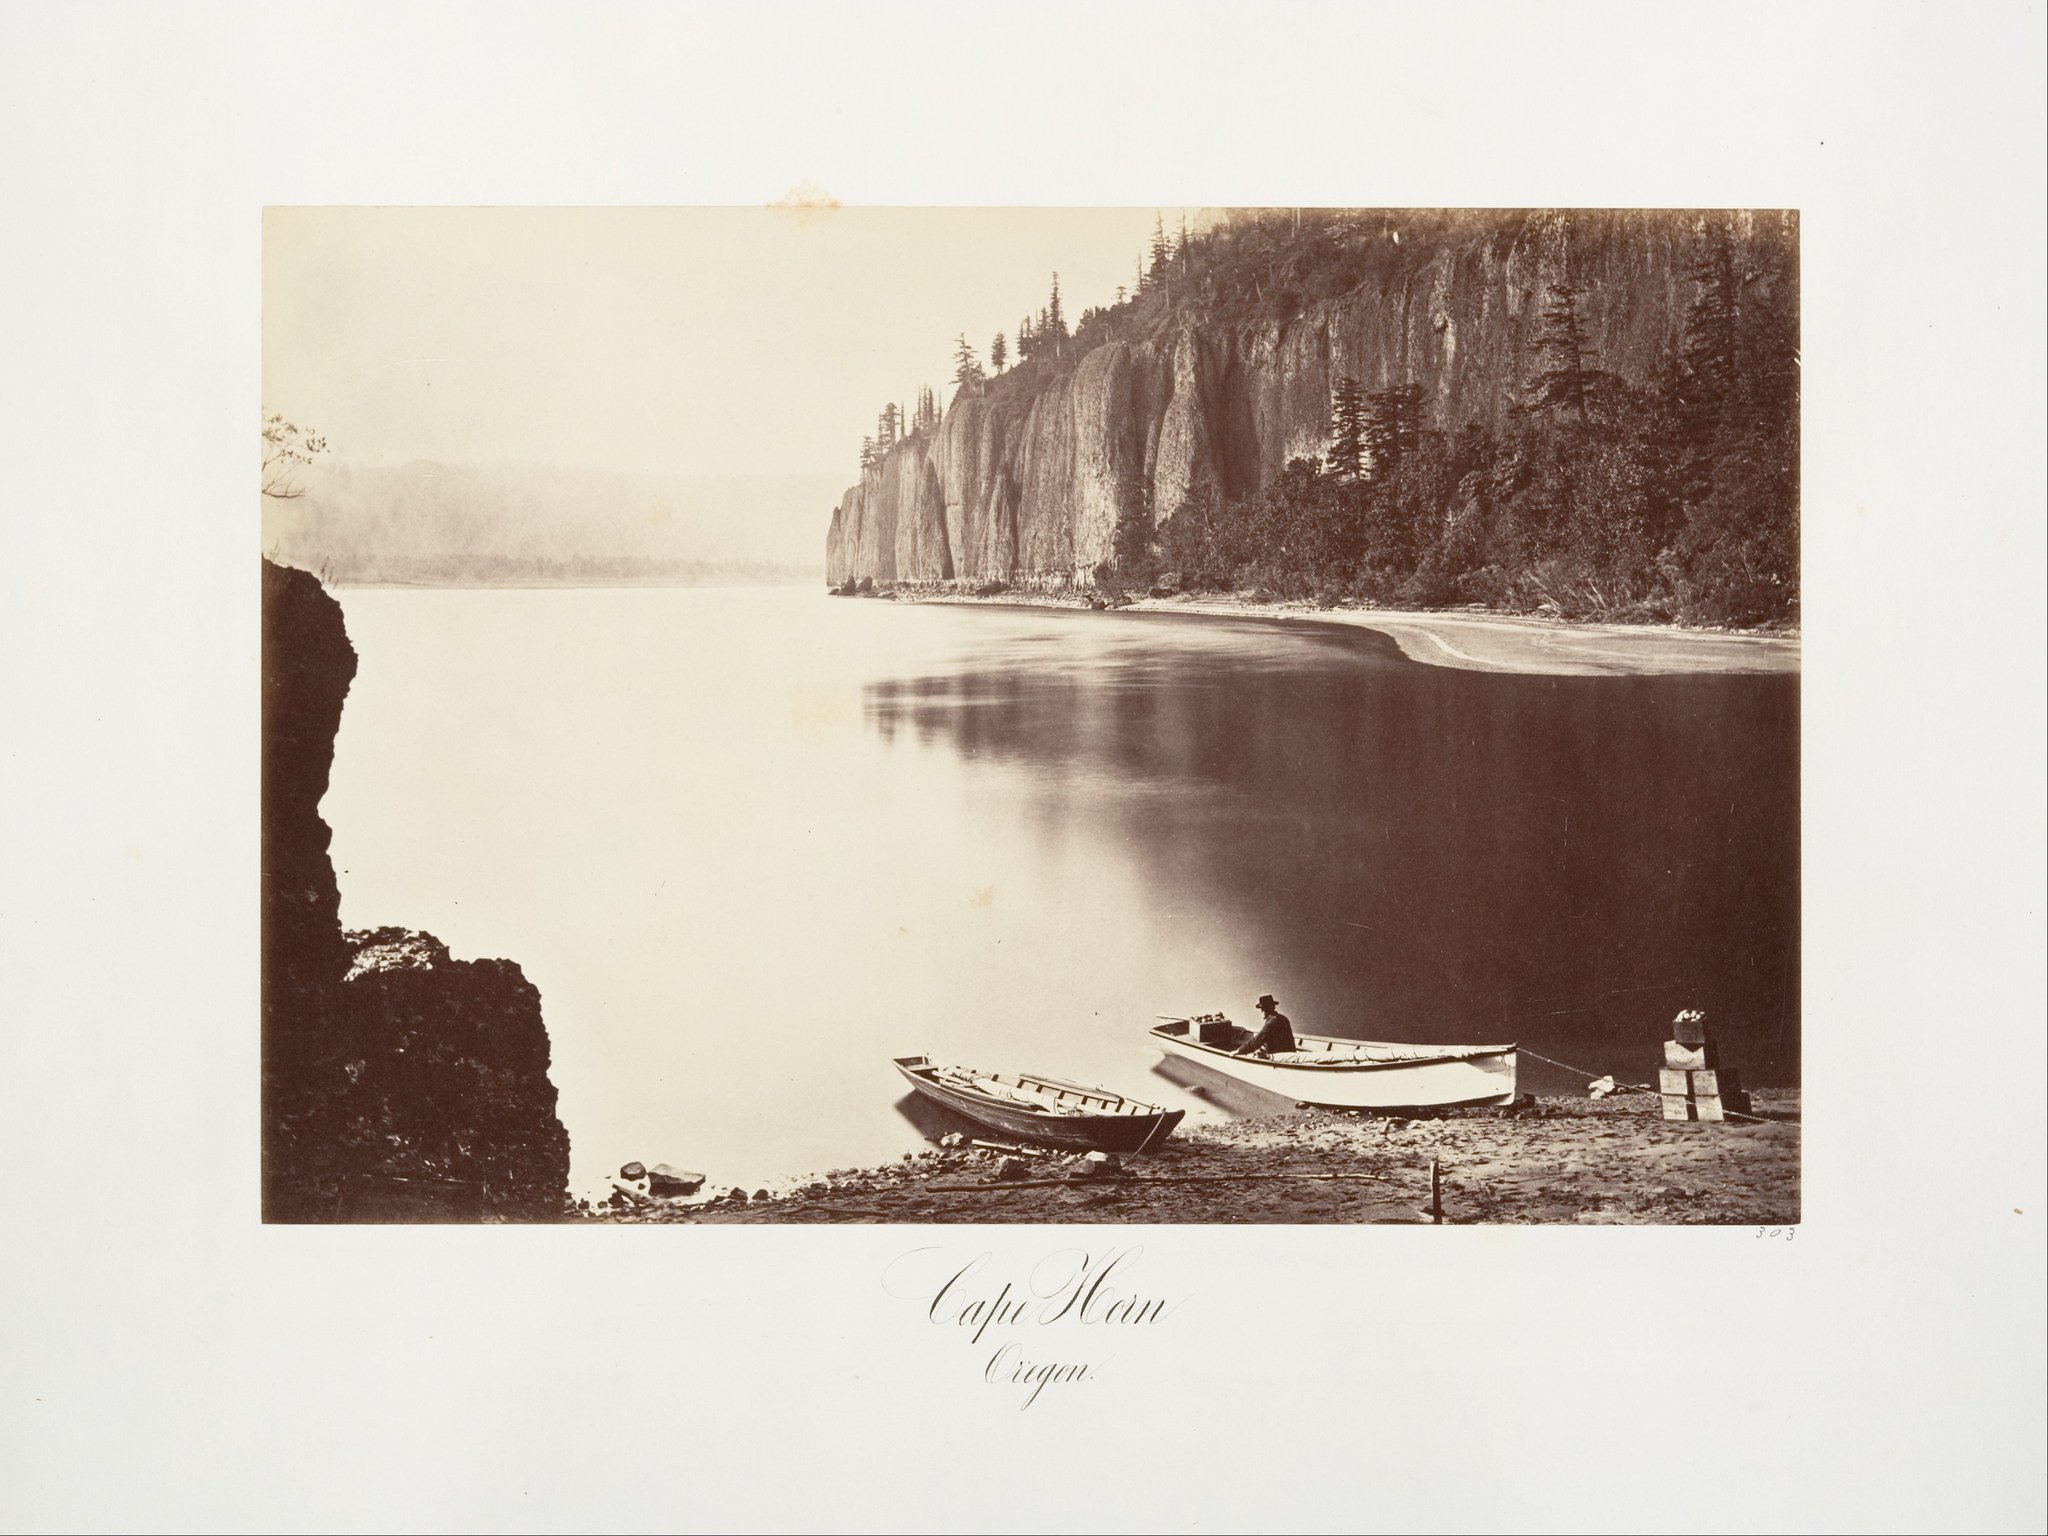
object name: photograph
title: Cape Horn, Oregon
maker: carleton e. watkins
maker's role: artist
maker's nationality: american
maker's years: 1829-1916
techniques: albumen silver print, glass negative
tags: landscapes,boats